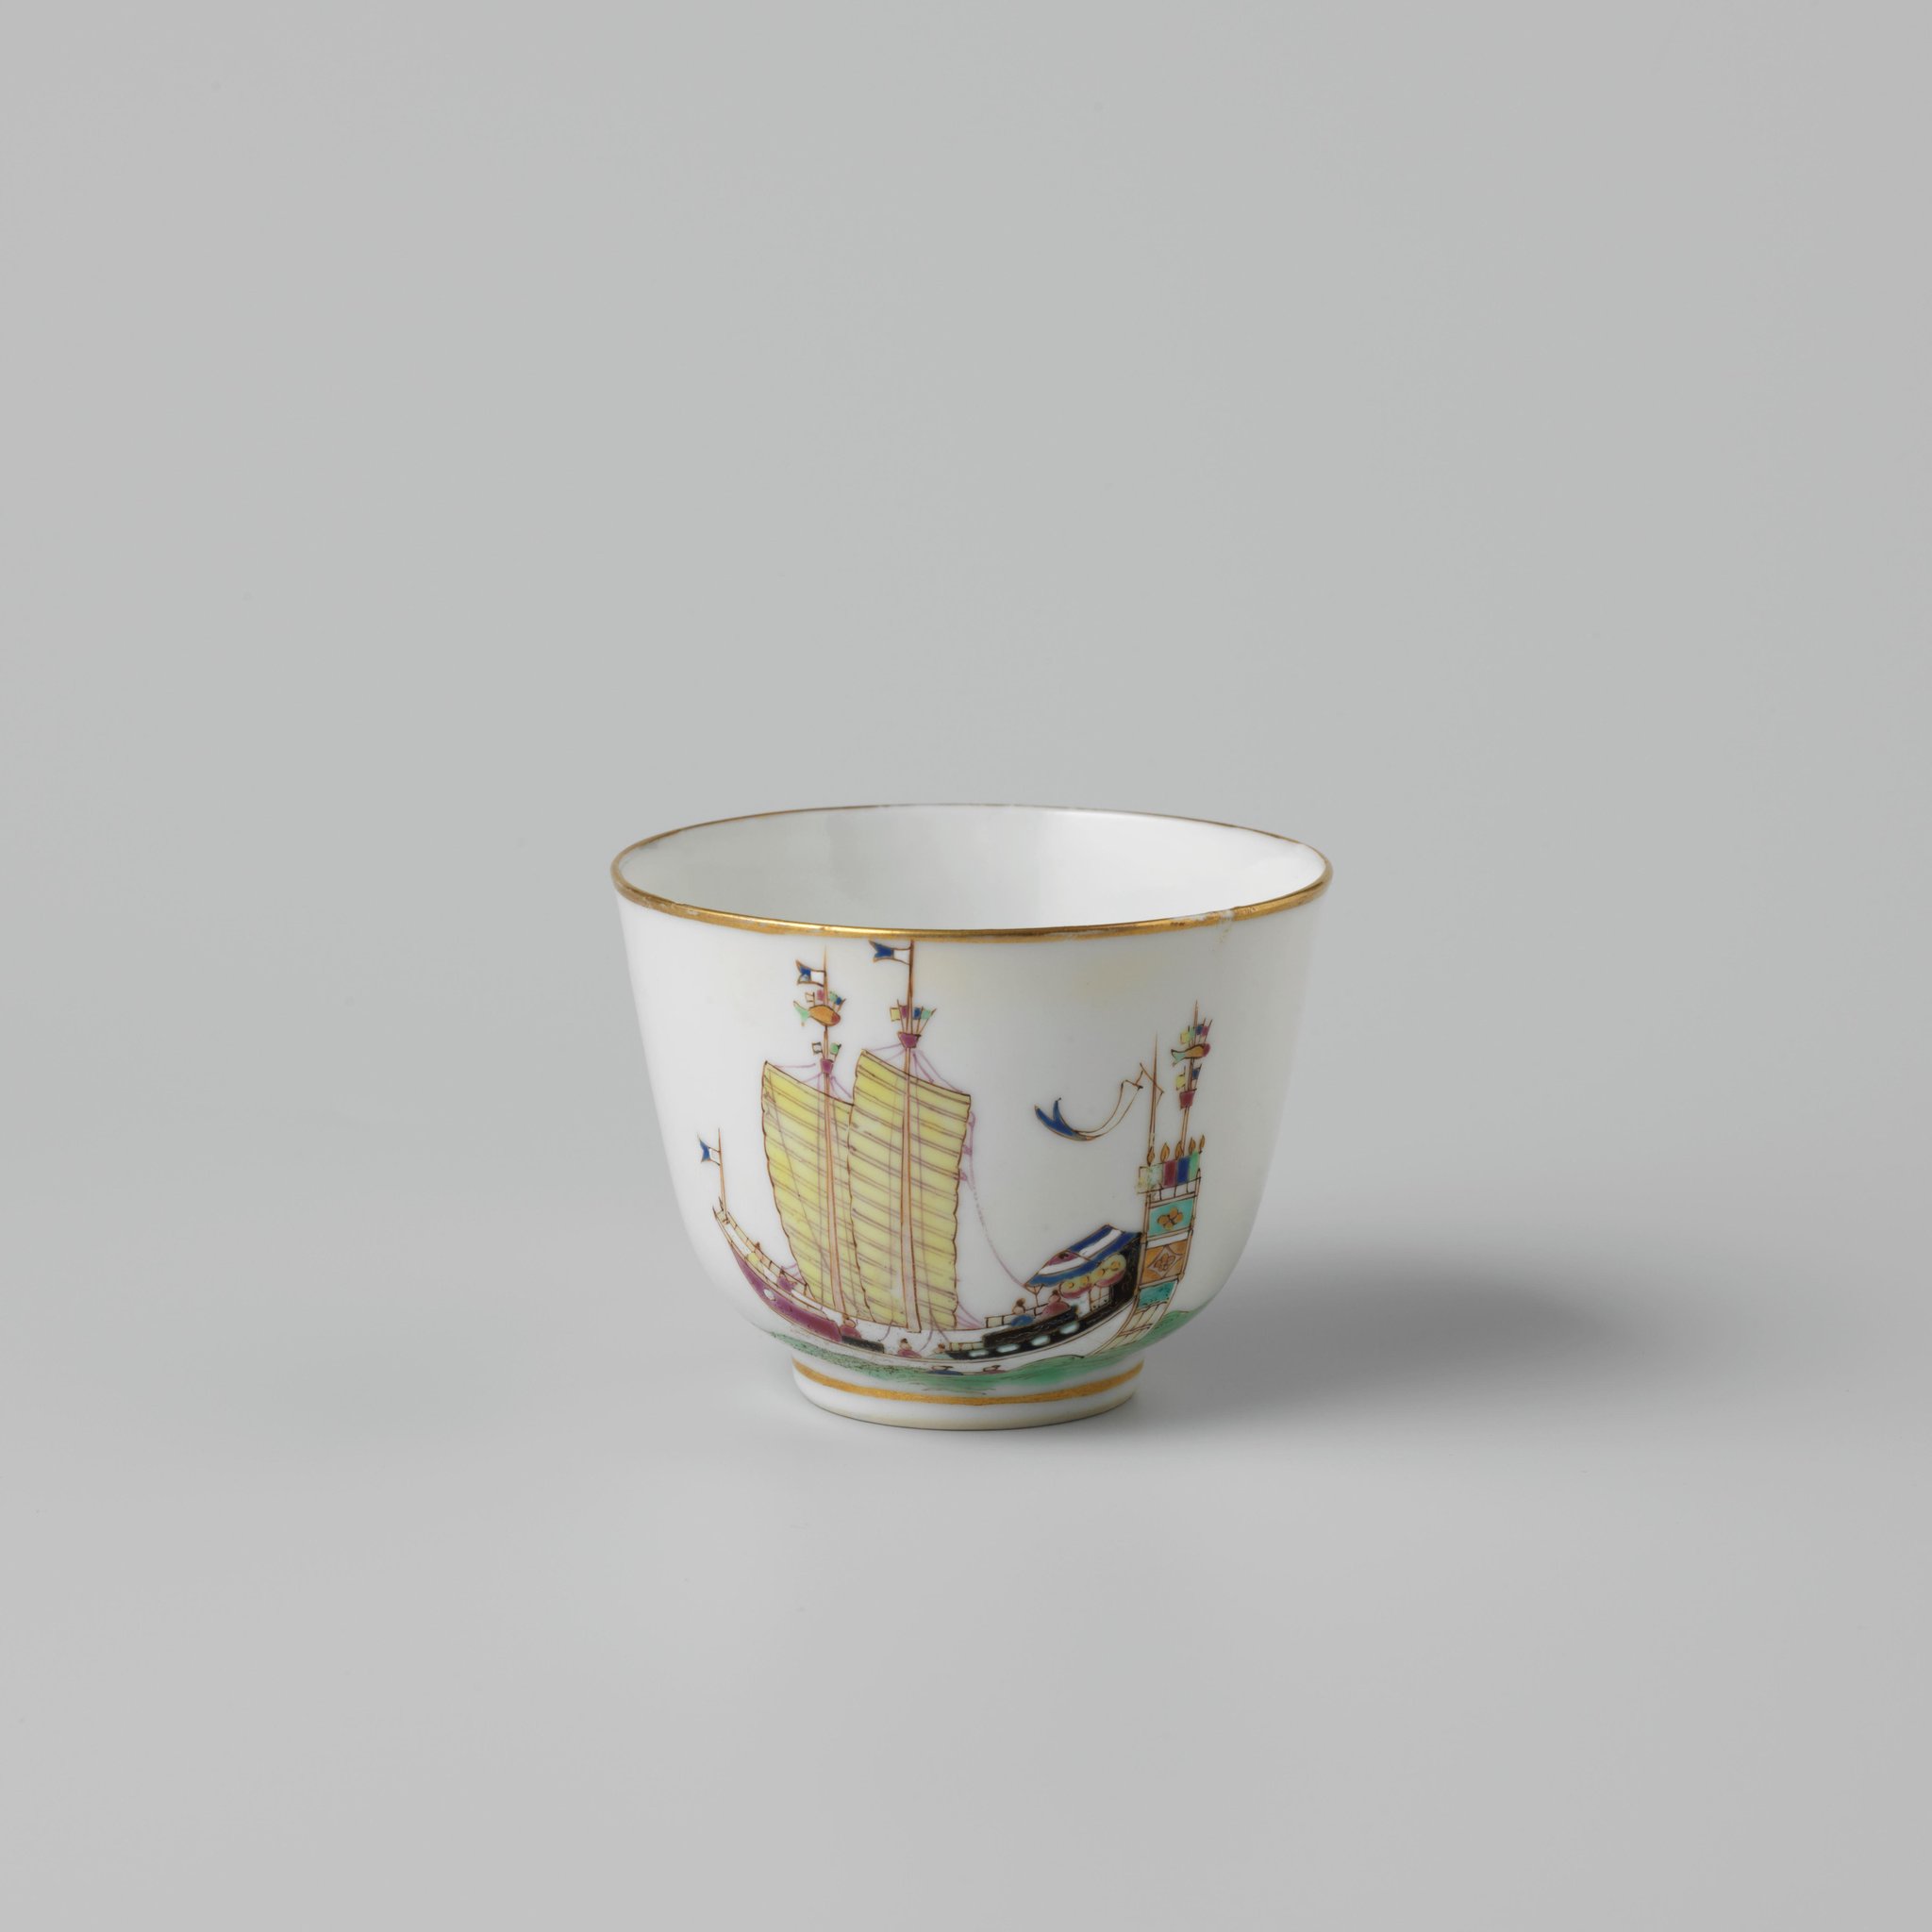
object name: cup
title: Cup with a Chinese junk and the arms of Amsterdam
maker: Anonymous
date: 1800-1899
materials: glaze, gold, paint, porcelain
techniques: firing, gilding, turning, vitrification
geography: china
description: Kop en schotel van porselein. de kop is versierd met aan de ene zijde het wapen van Amsterdam, gehouden door twee leeuwen, en aan de andere zijde een Chineesche jonk. Op de schotel staat dezelfde versiering. 'Chine de Commande'.